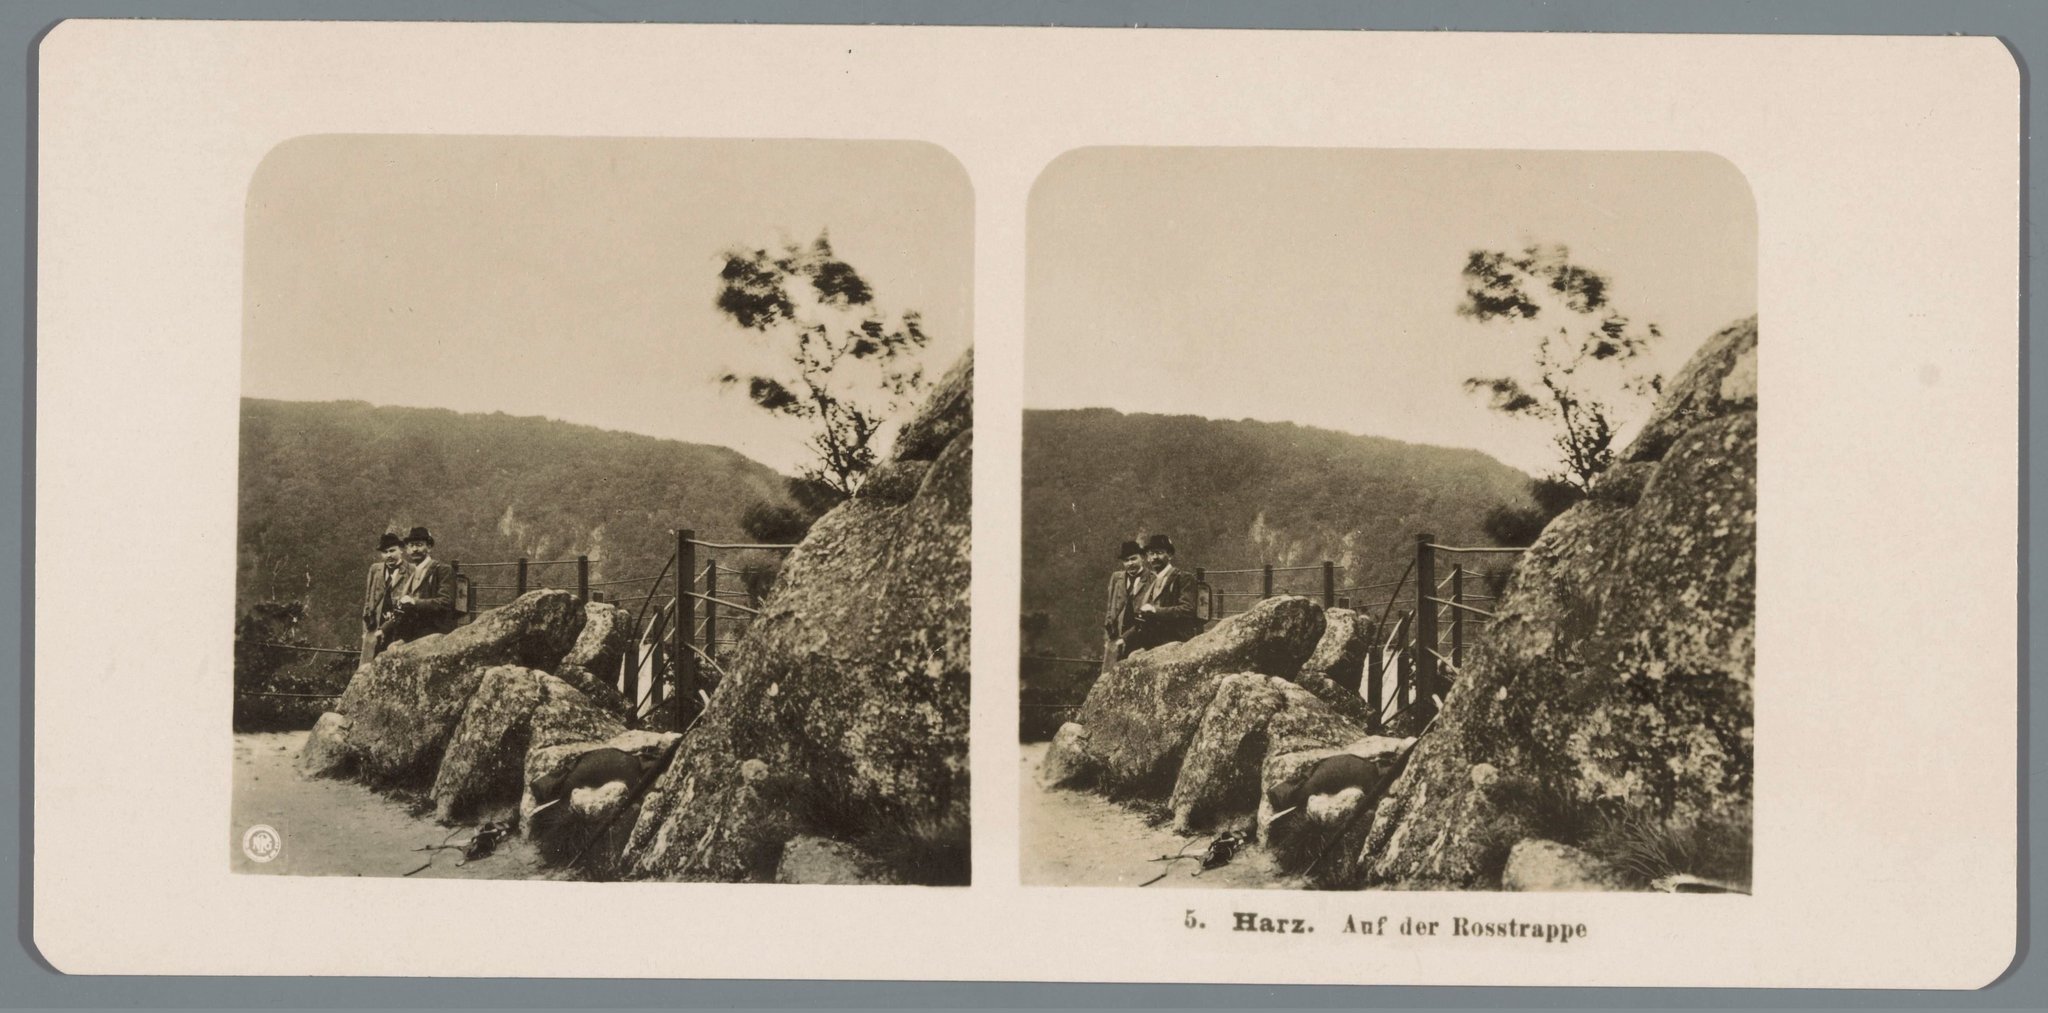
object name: stereograph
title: Harz. Auf der Rosstrappe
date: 1904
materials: cardboard, photographic support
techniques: gelatin silver print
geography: roßtrappe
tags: mountain-top, peak, road, path, mountains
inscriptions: inscription: ‘NPG’, number: ‘5.’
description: RP-F-00-9007 is een ander exemplaar van dezelfde foto.